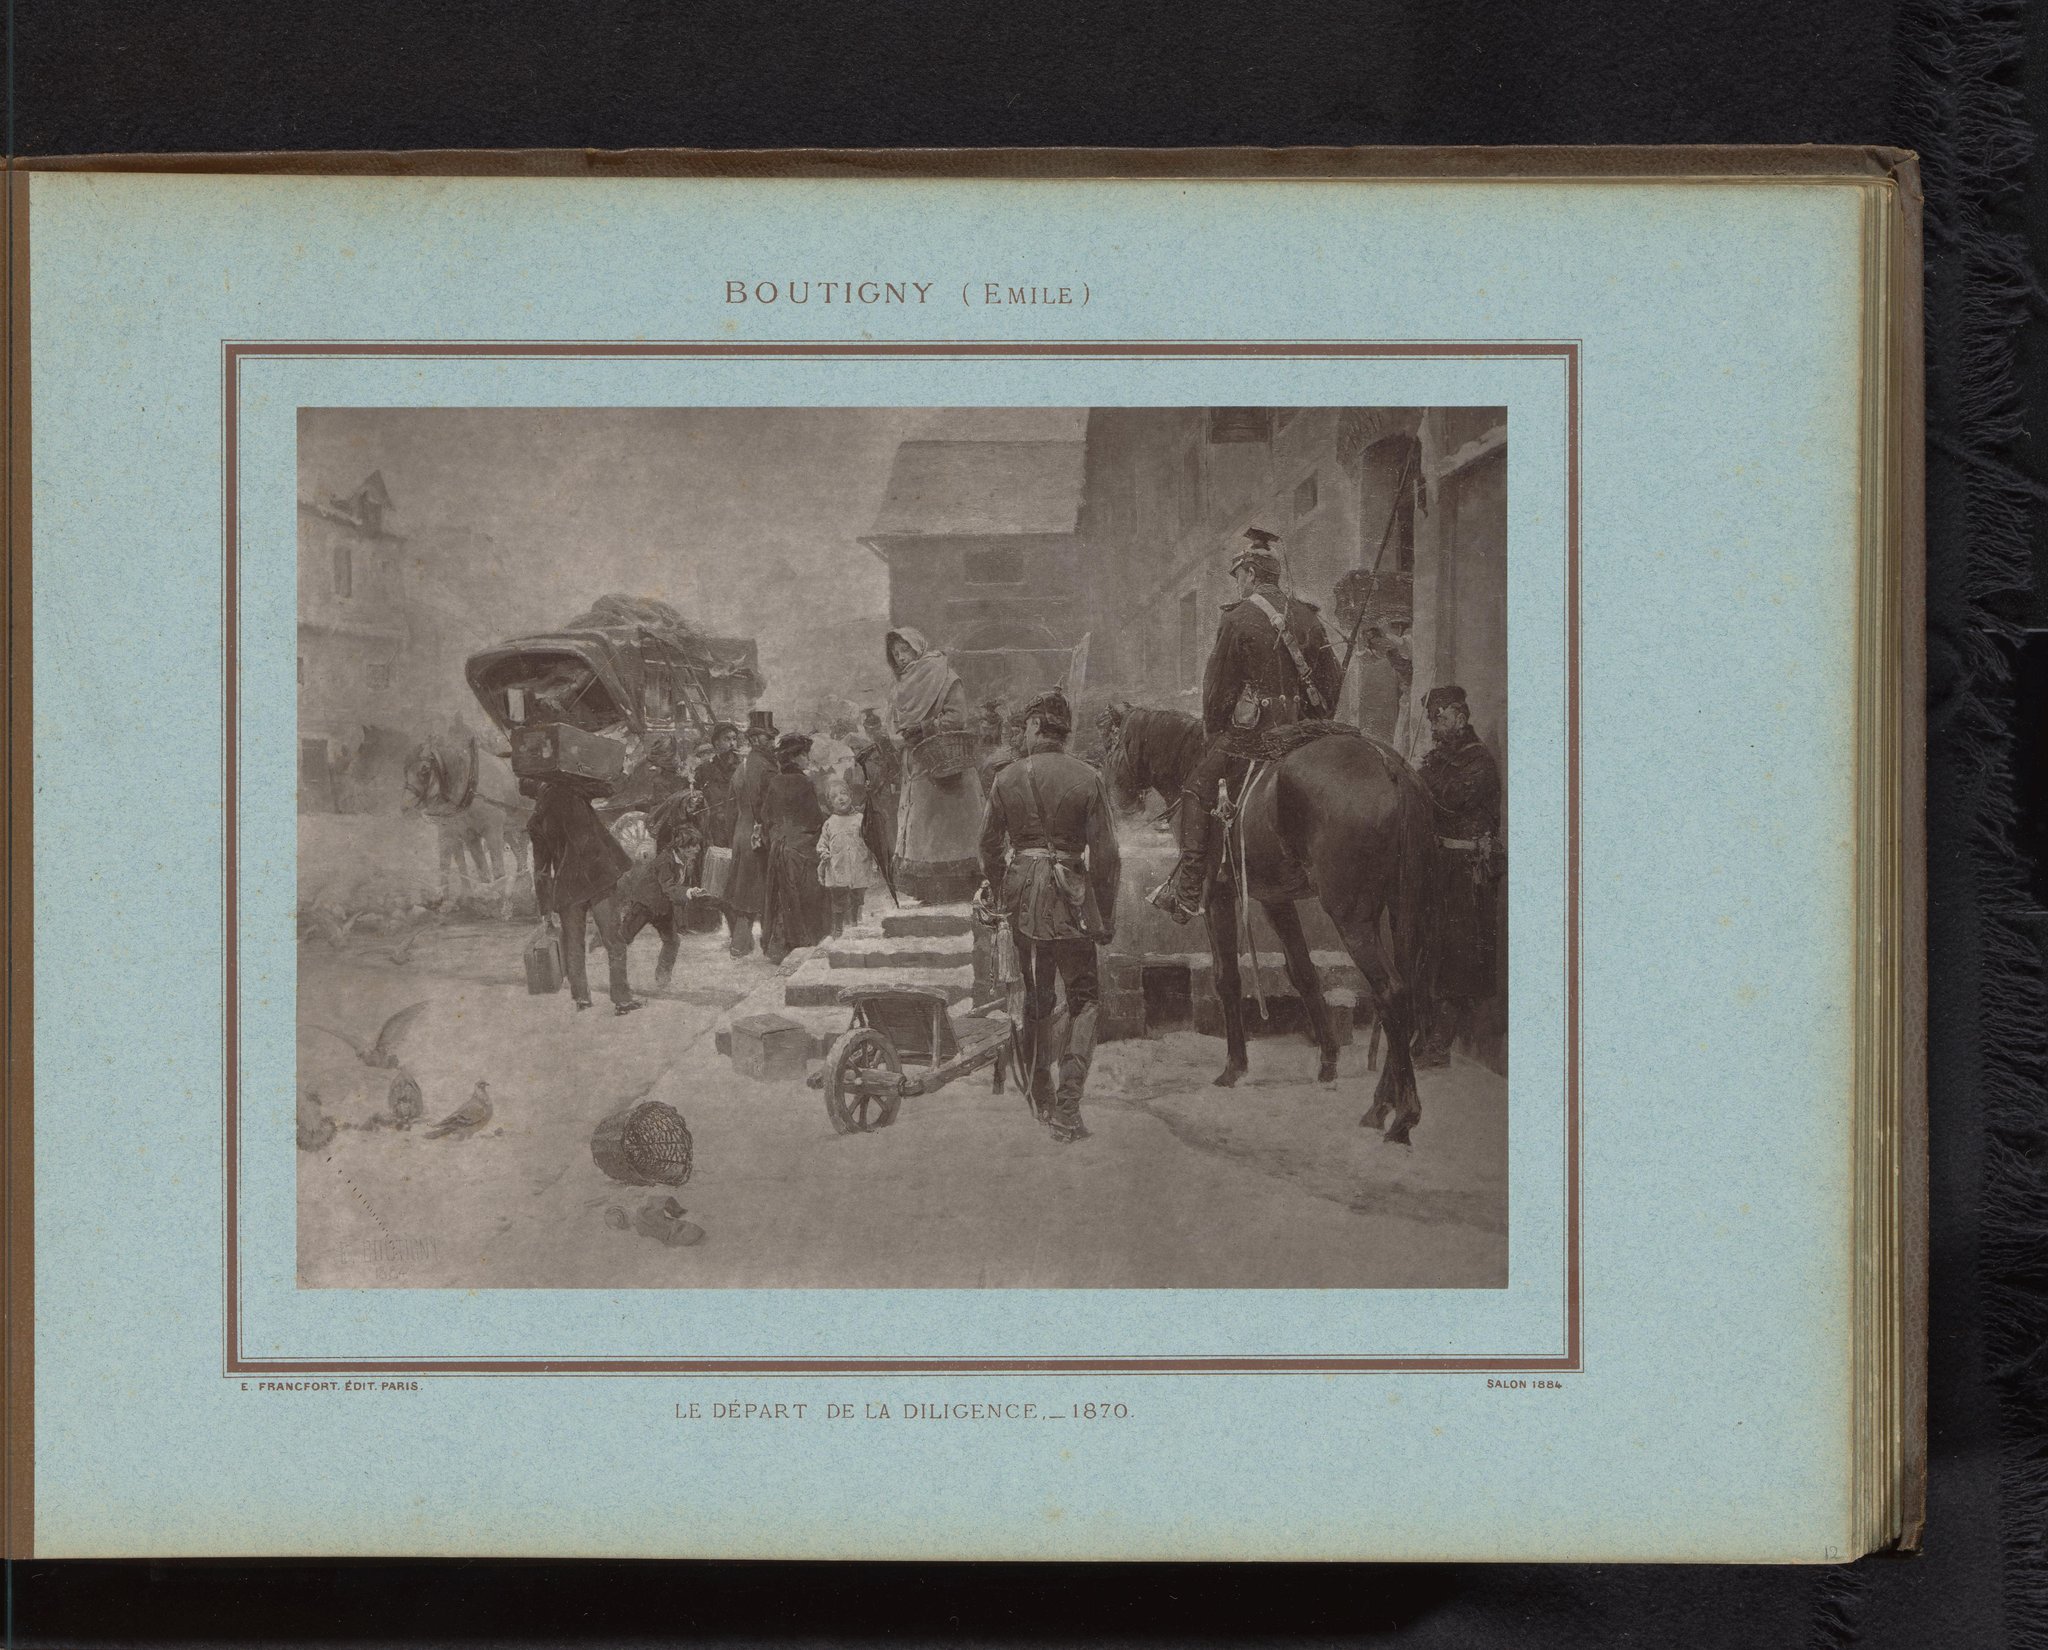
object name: page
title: Le Départ de la Diligence. - 1870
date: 1884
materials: paper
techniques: woodburytype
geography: paris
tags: taking leave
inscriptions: name: ‘Boutigny (Emile)’, inscription: ‘SALON 1884.’